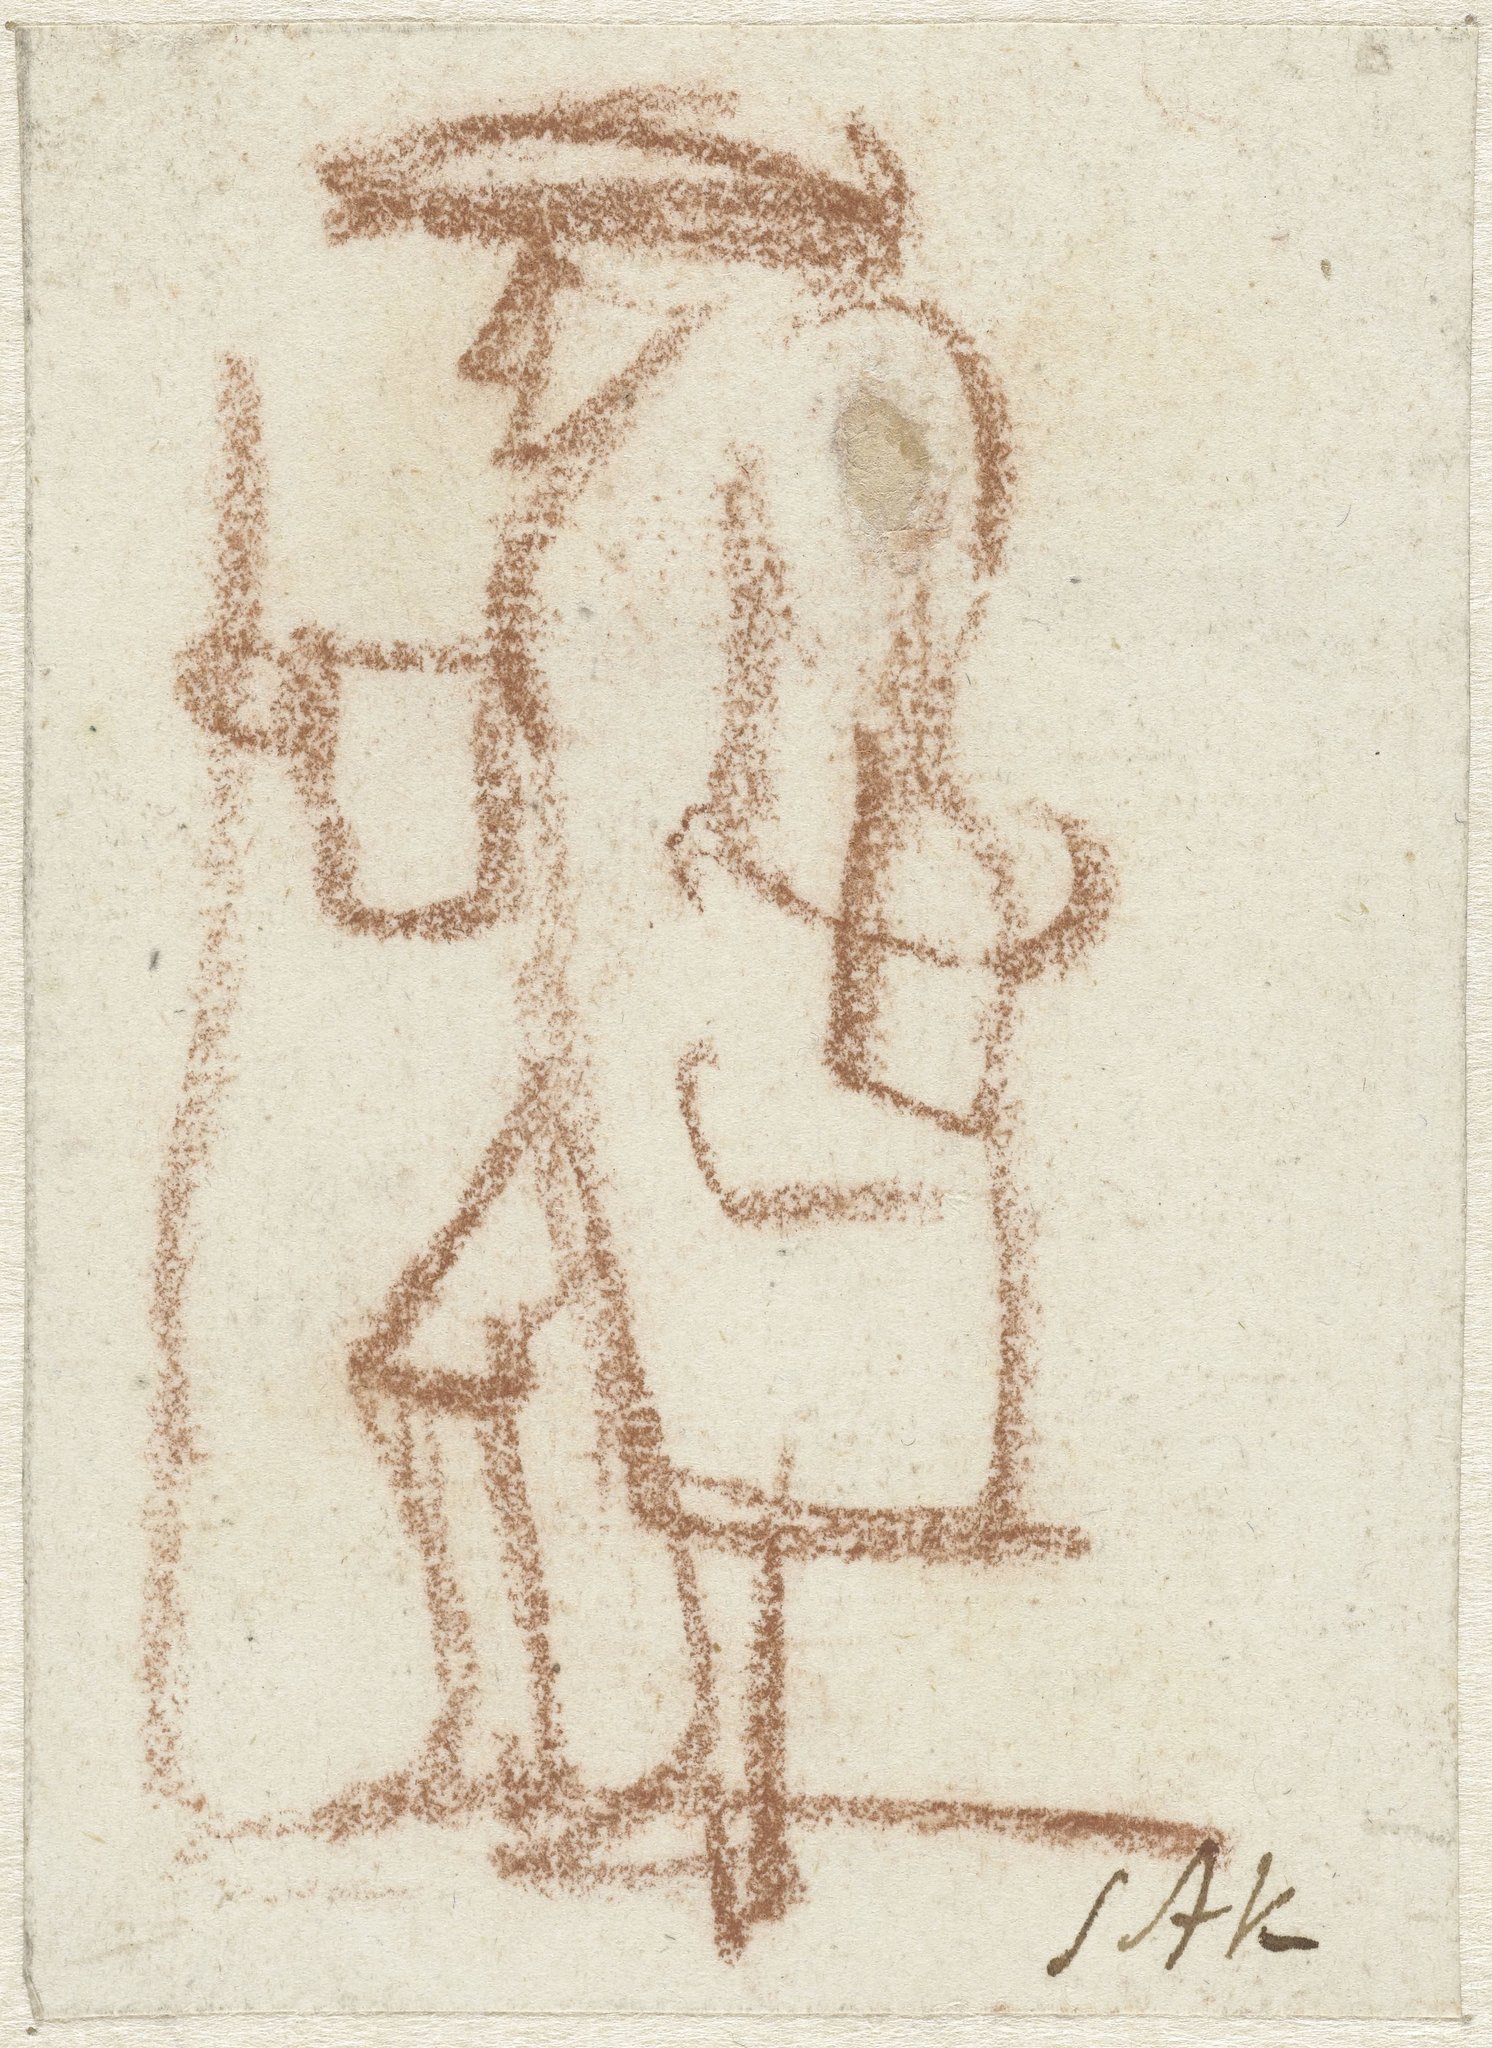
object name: drawing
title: Staande man met stok, naar links, van opzij gezien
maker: simon andreas krausz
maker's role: draughtsman, print maker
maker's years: 1760-1825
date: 1770-1825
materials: chalk, paper